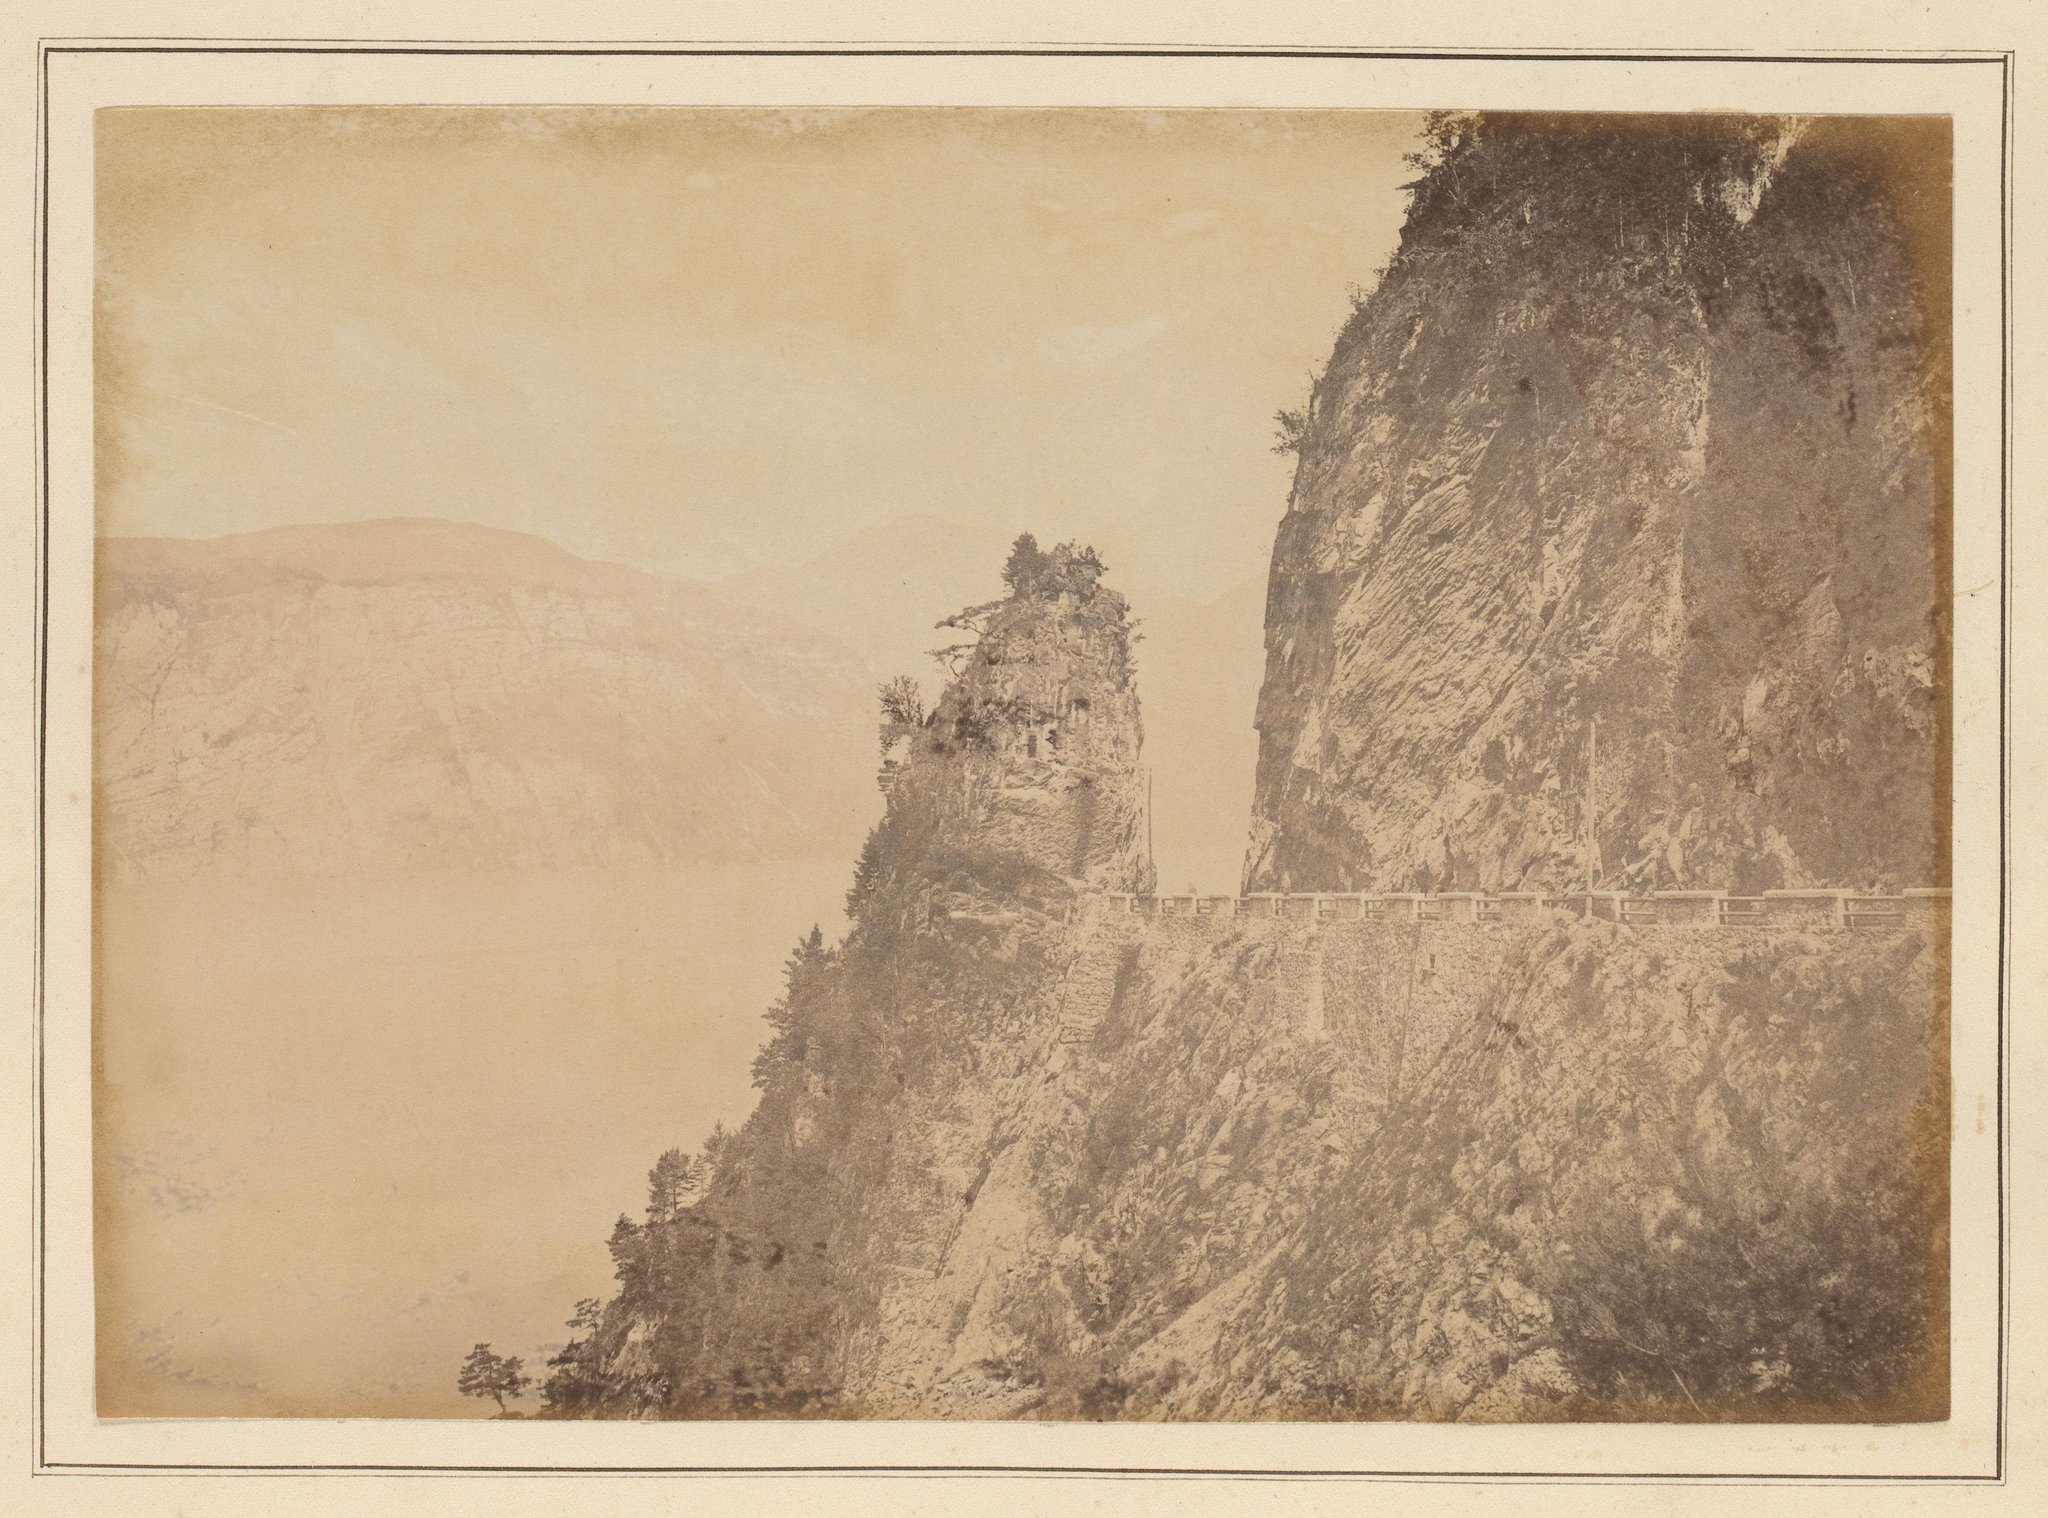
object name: album leaf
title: Axenstrasse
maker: Anonymous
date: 1870-1890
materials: paper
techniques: albumen print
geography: axenstrasse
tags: public road, mountains